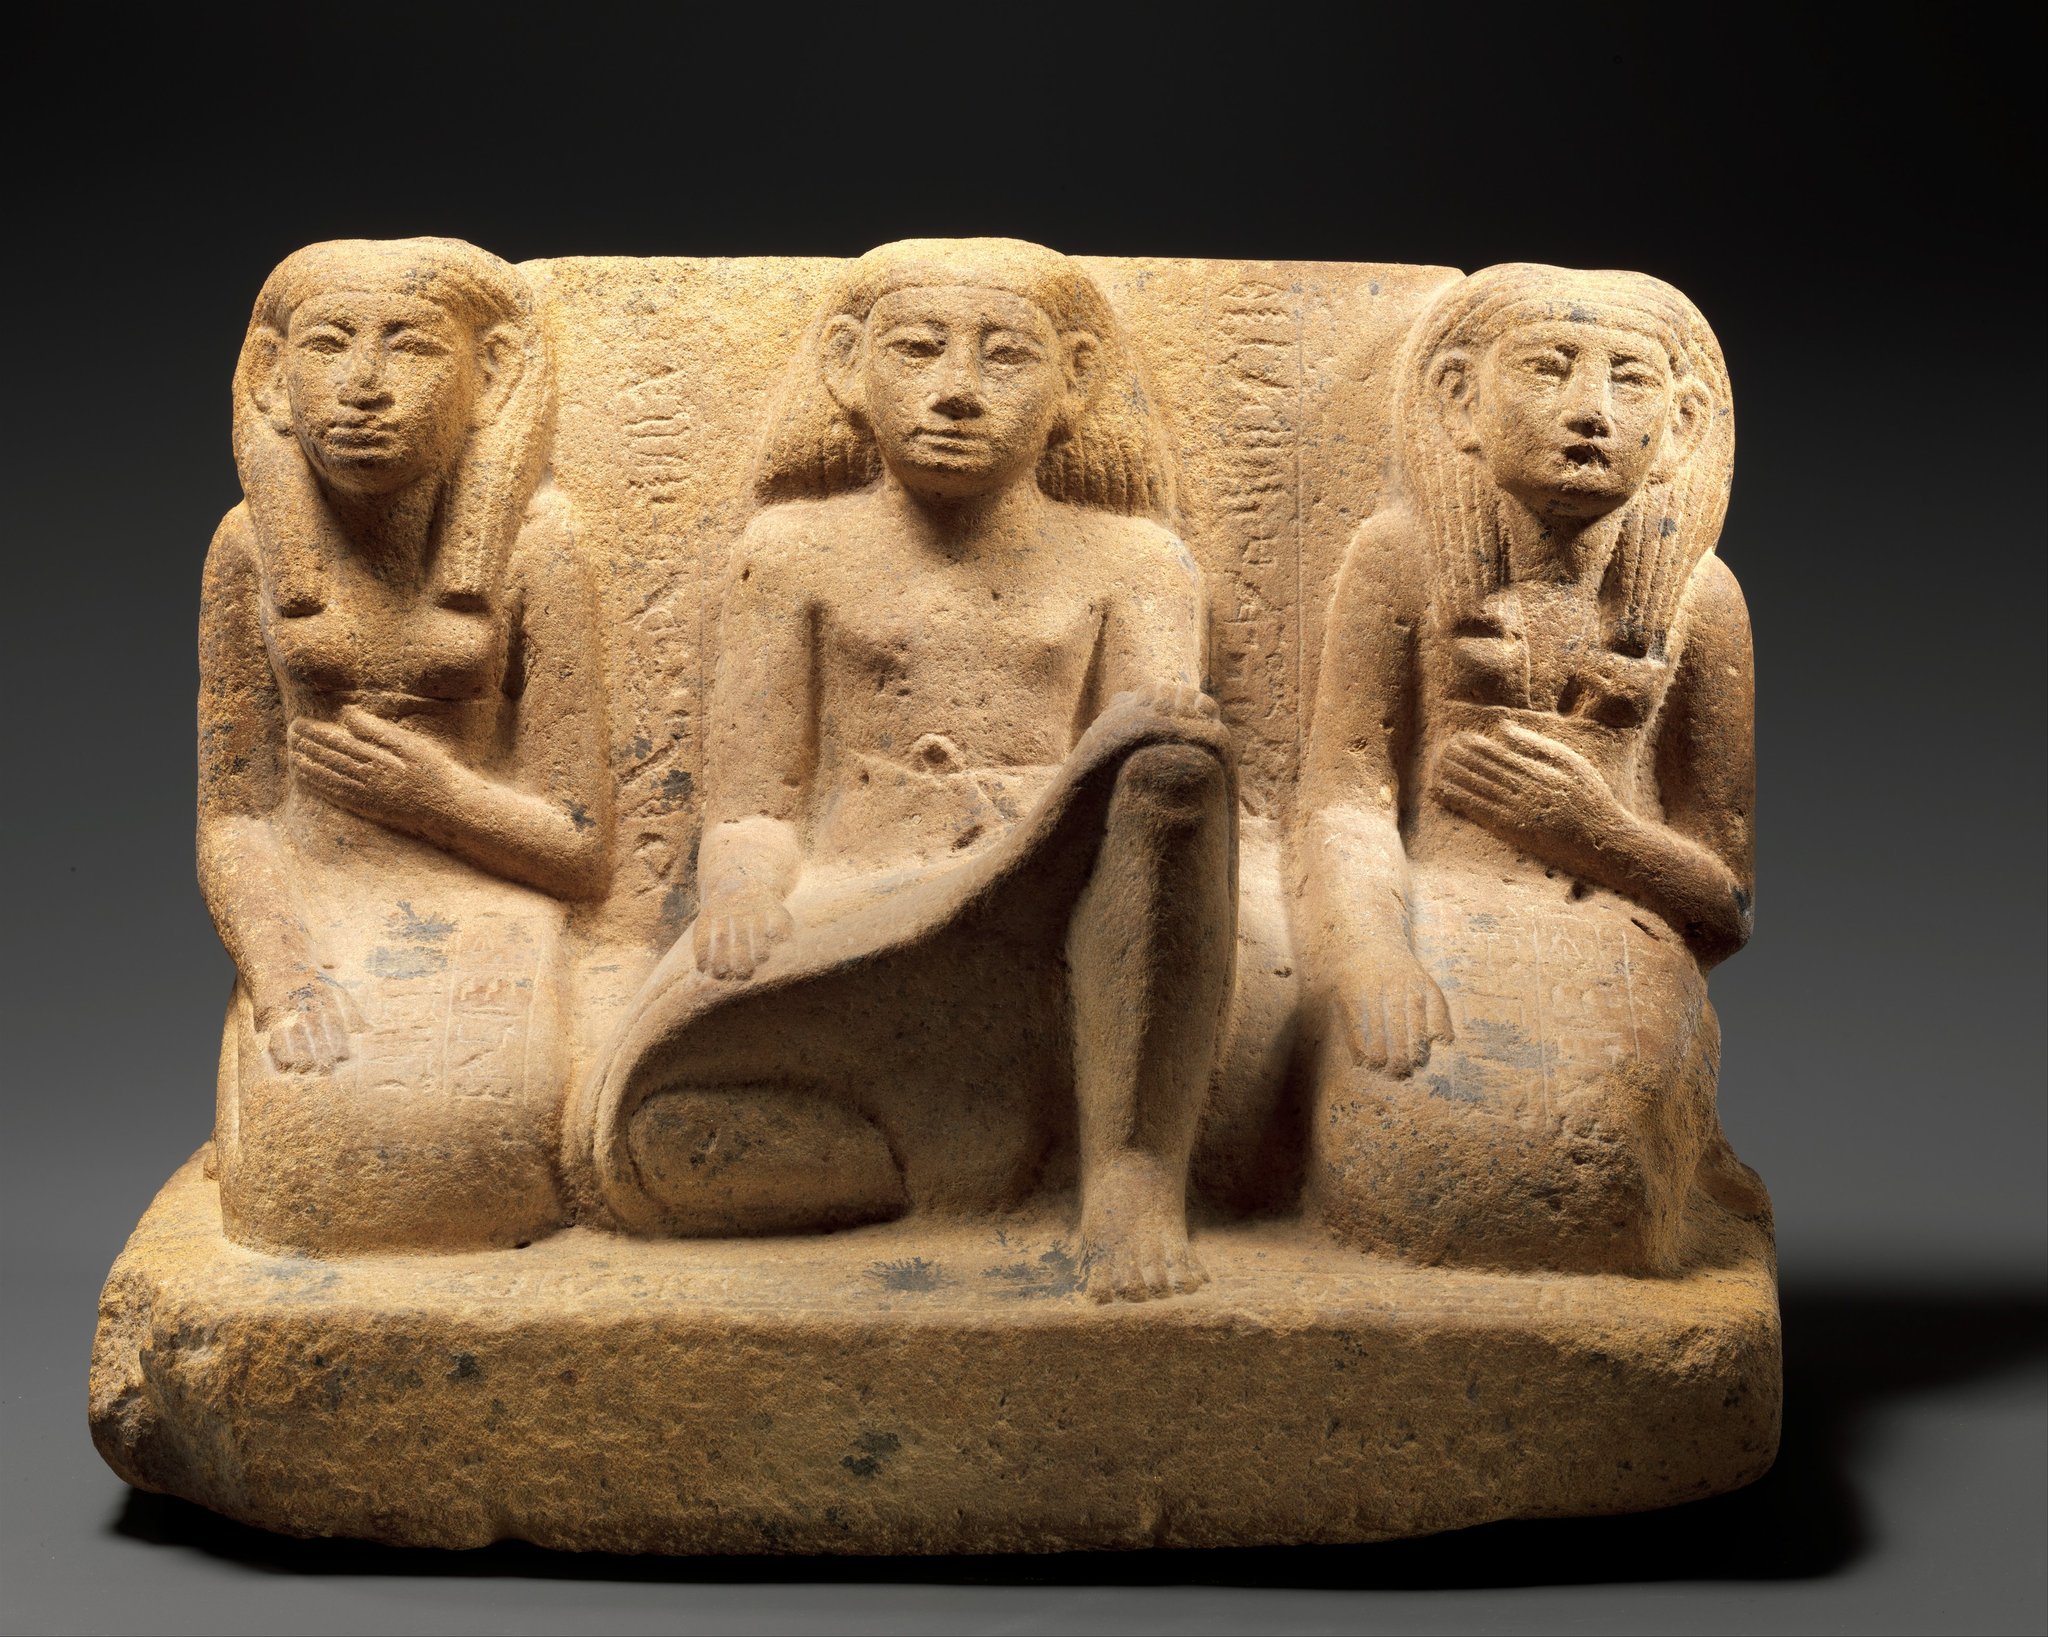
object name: statue, hetepsebek, senbebu, two woman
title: Statue of the Overseer of Stonemasons Senbebu and Family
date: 1981-1802 BCE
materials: stone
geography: southern upper egypt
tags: men,women,family